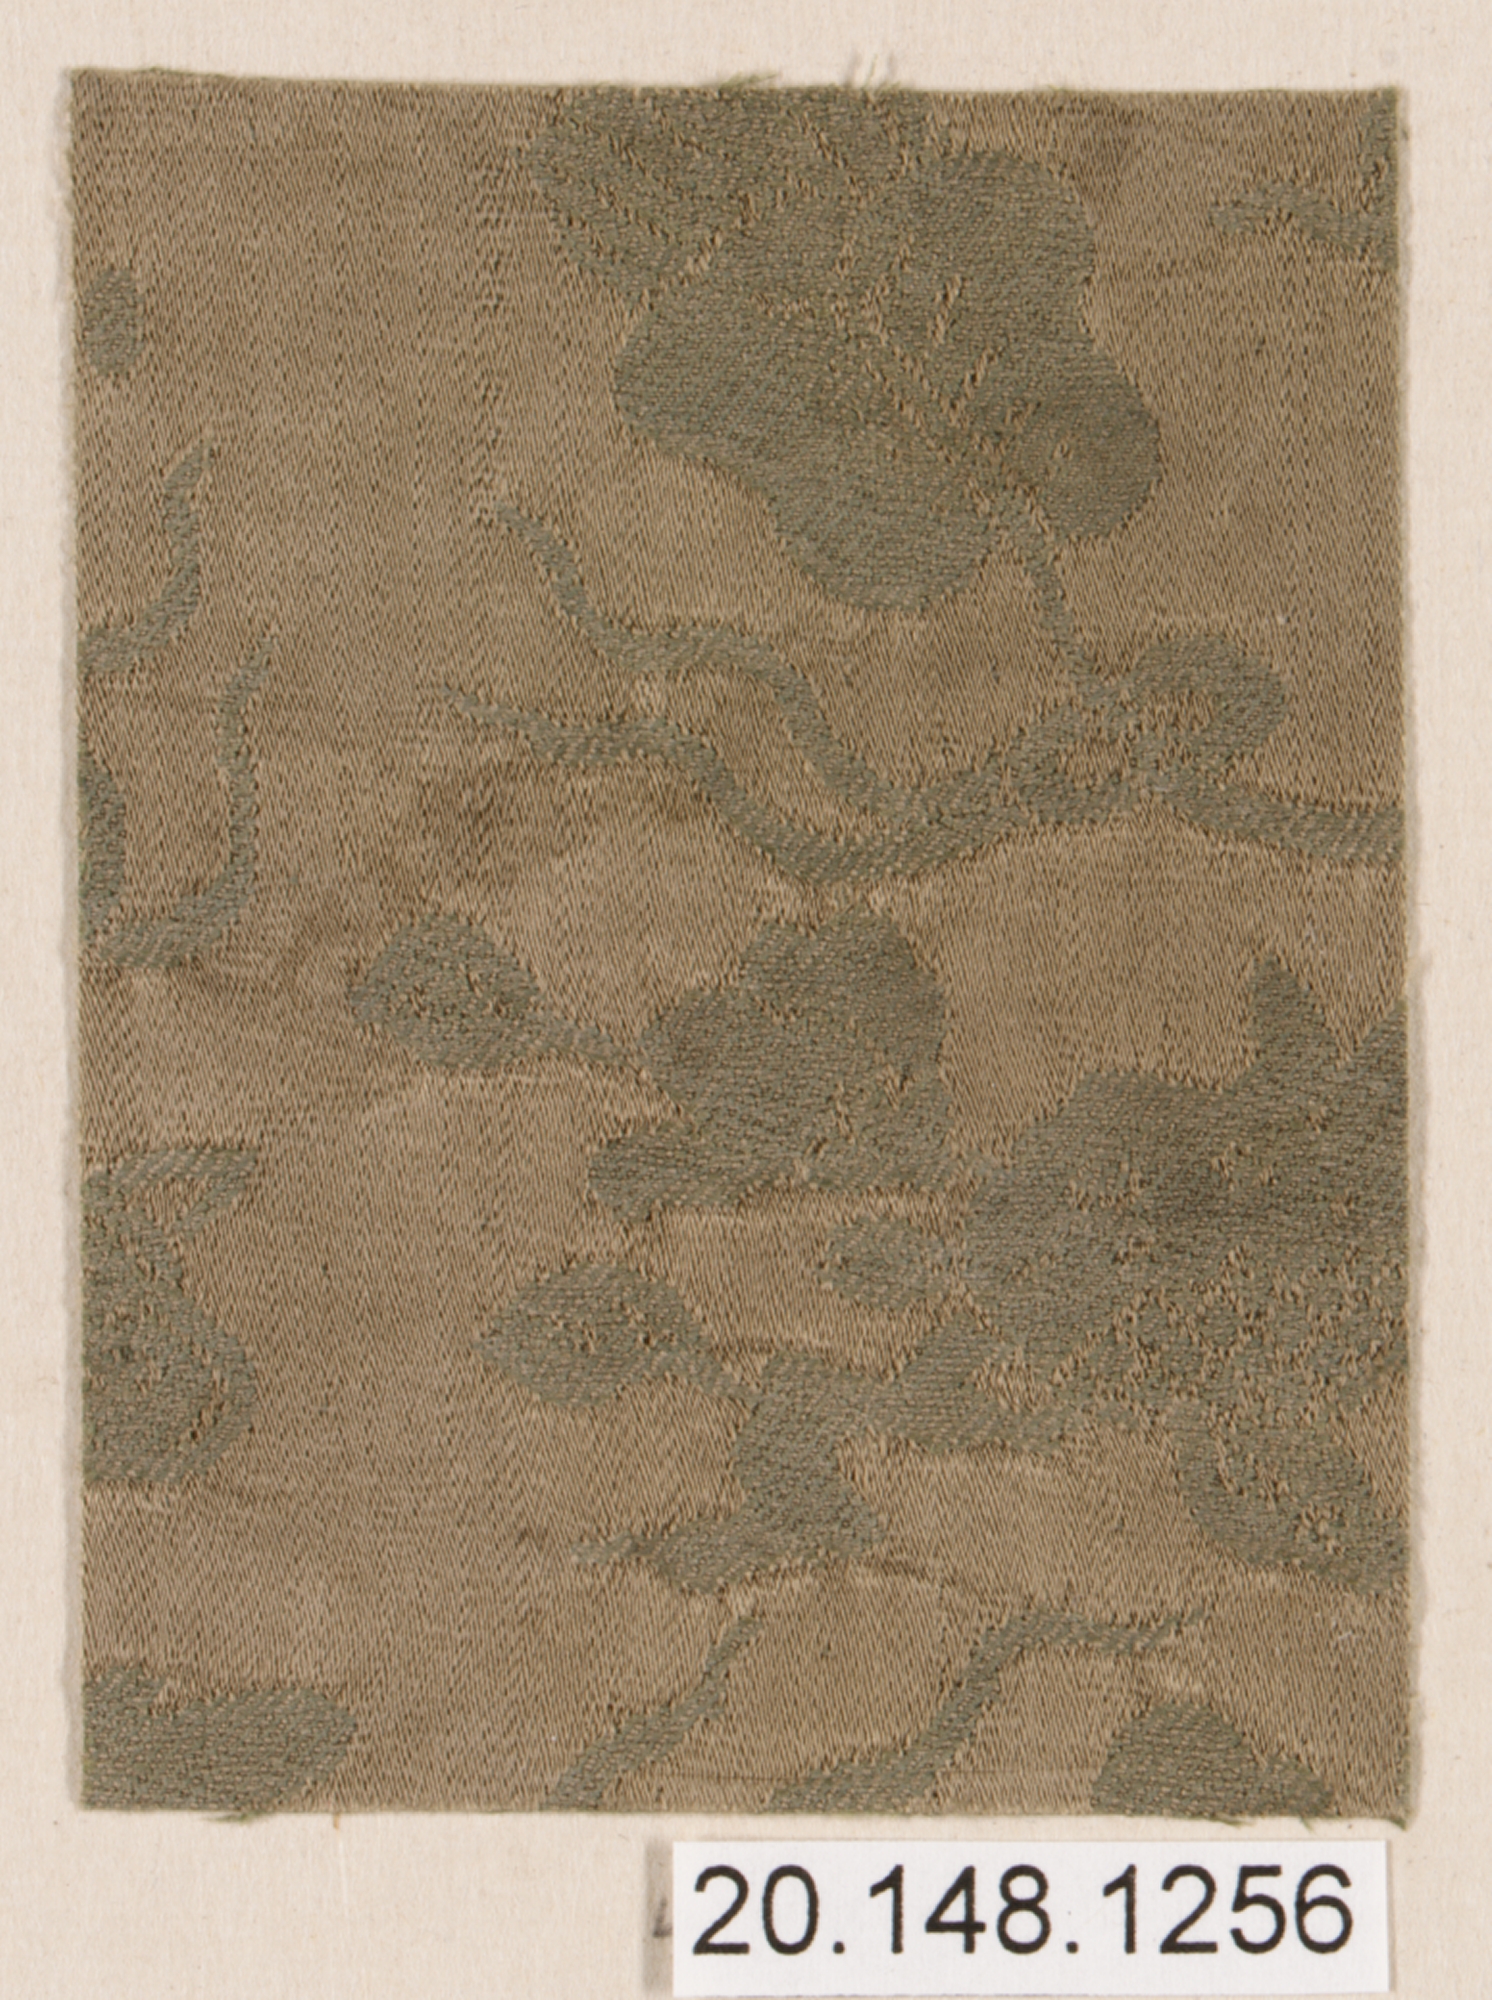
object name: piece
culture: japanese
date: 1701-1800